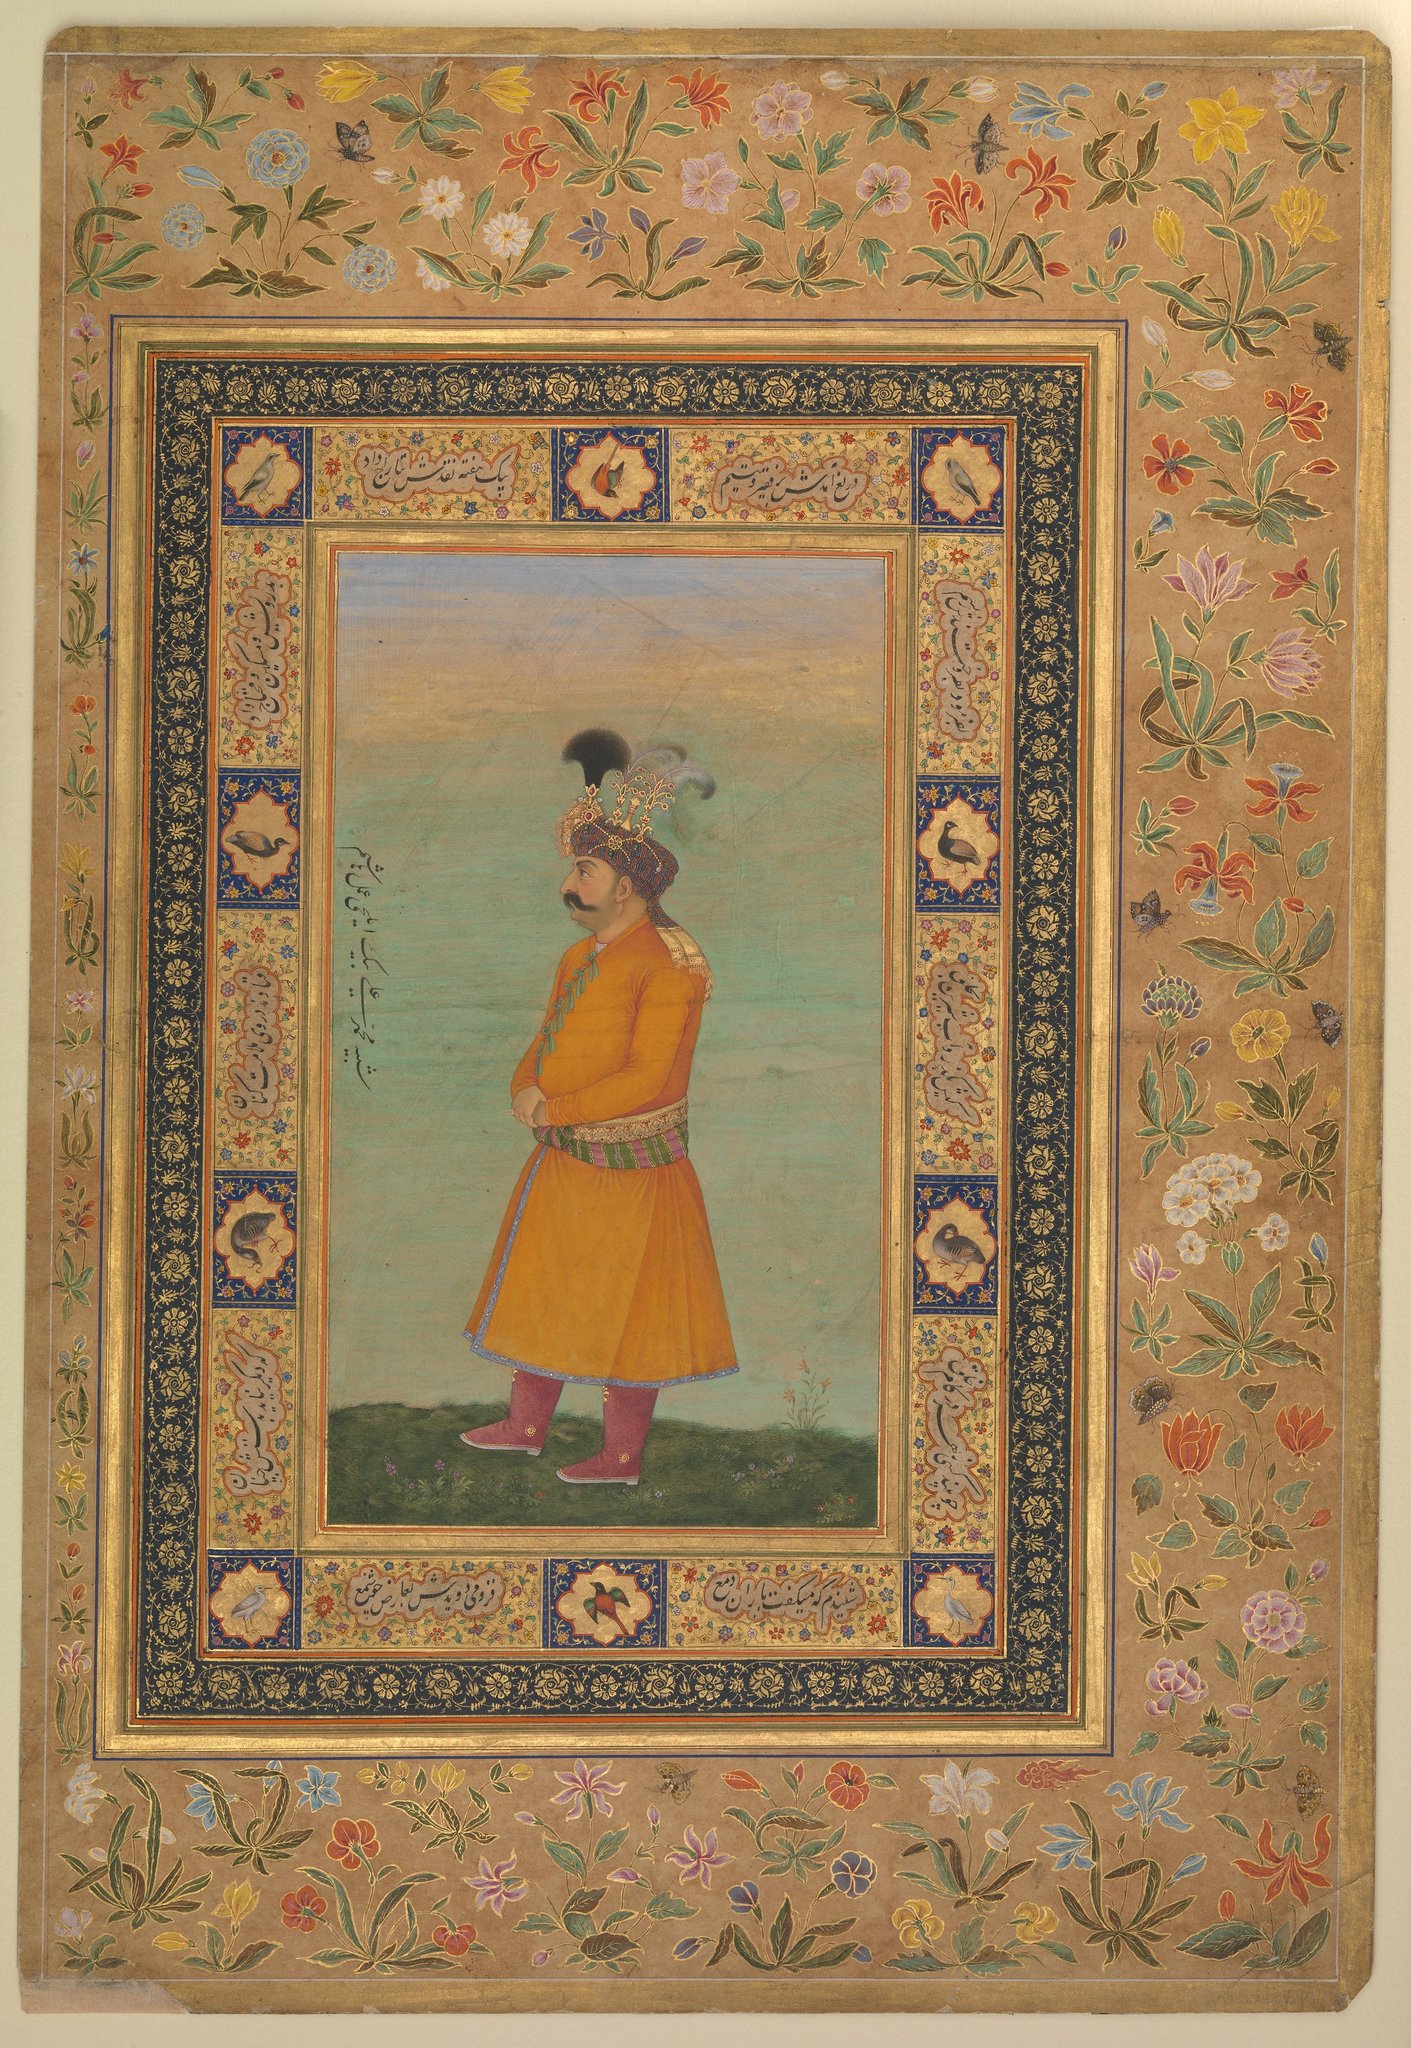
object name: album leaf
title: "Portrait of Muhammad Ali Baig", Folio from the Shah Jahan Album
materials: gold, ink, paper, watercolor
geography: india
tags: men,profiles,flowers